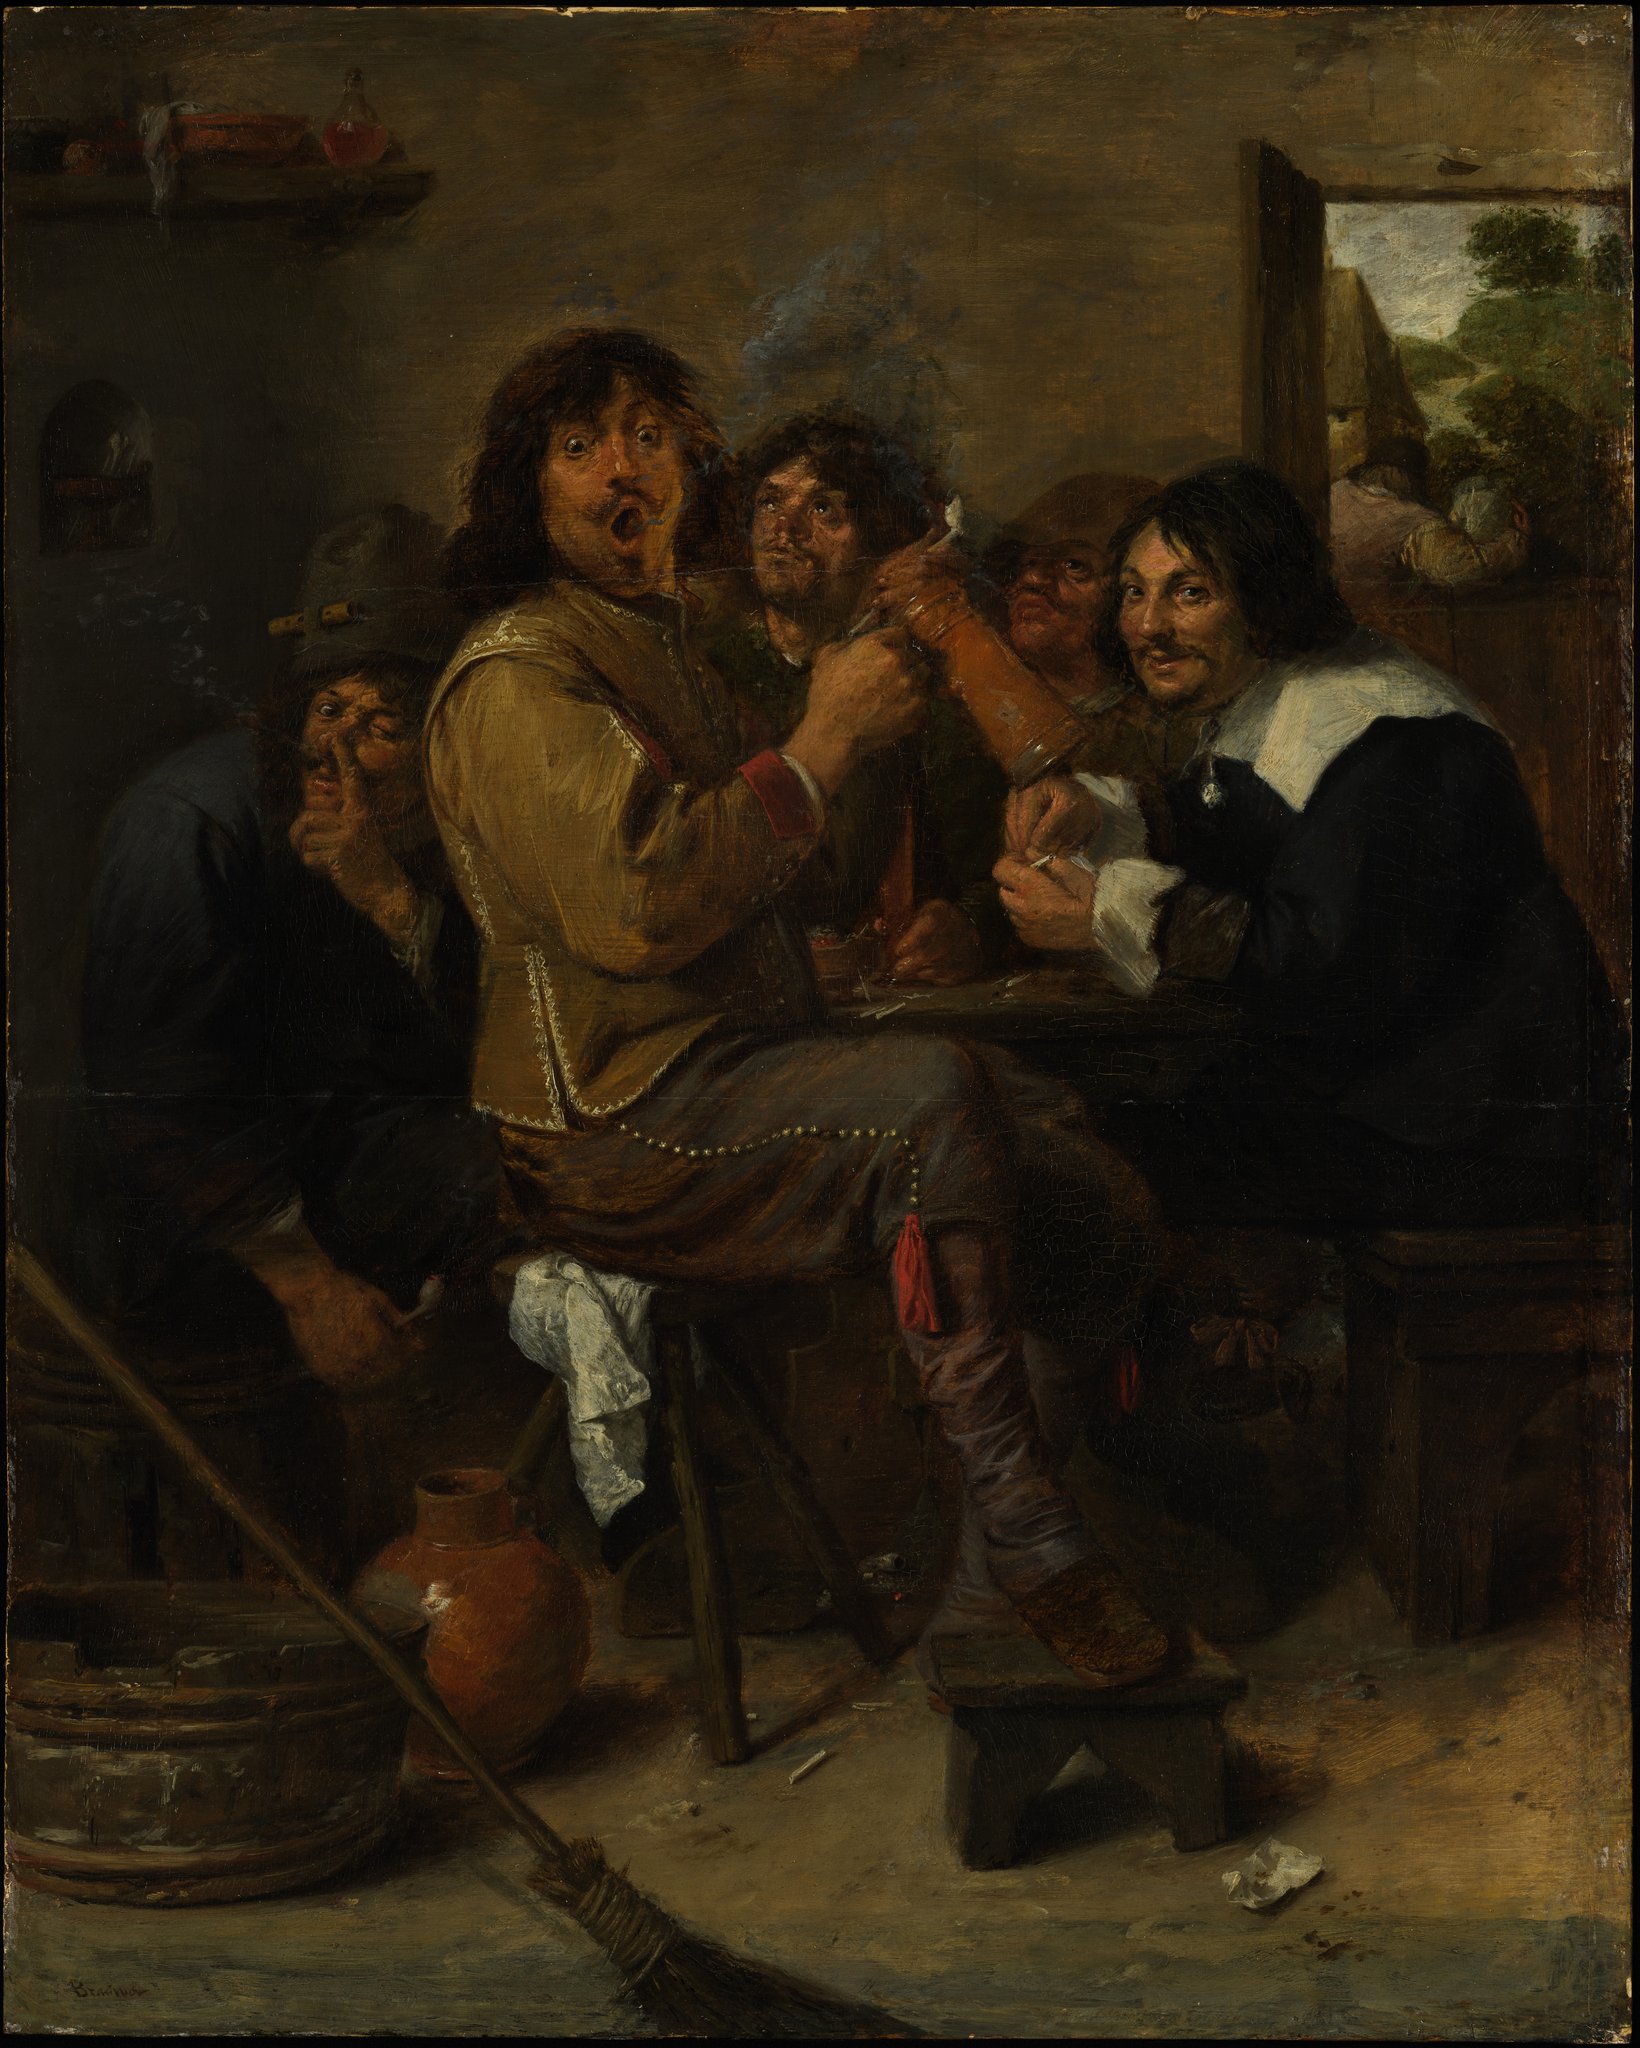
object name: painting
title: The Smokers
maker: adriaen brouwer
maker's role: artist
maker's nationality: flemish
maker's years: 1605-1638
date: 1636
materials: oil, wood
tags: men,smoking,tankards